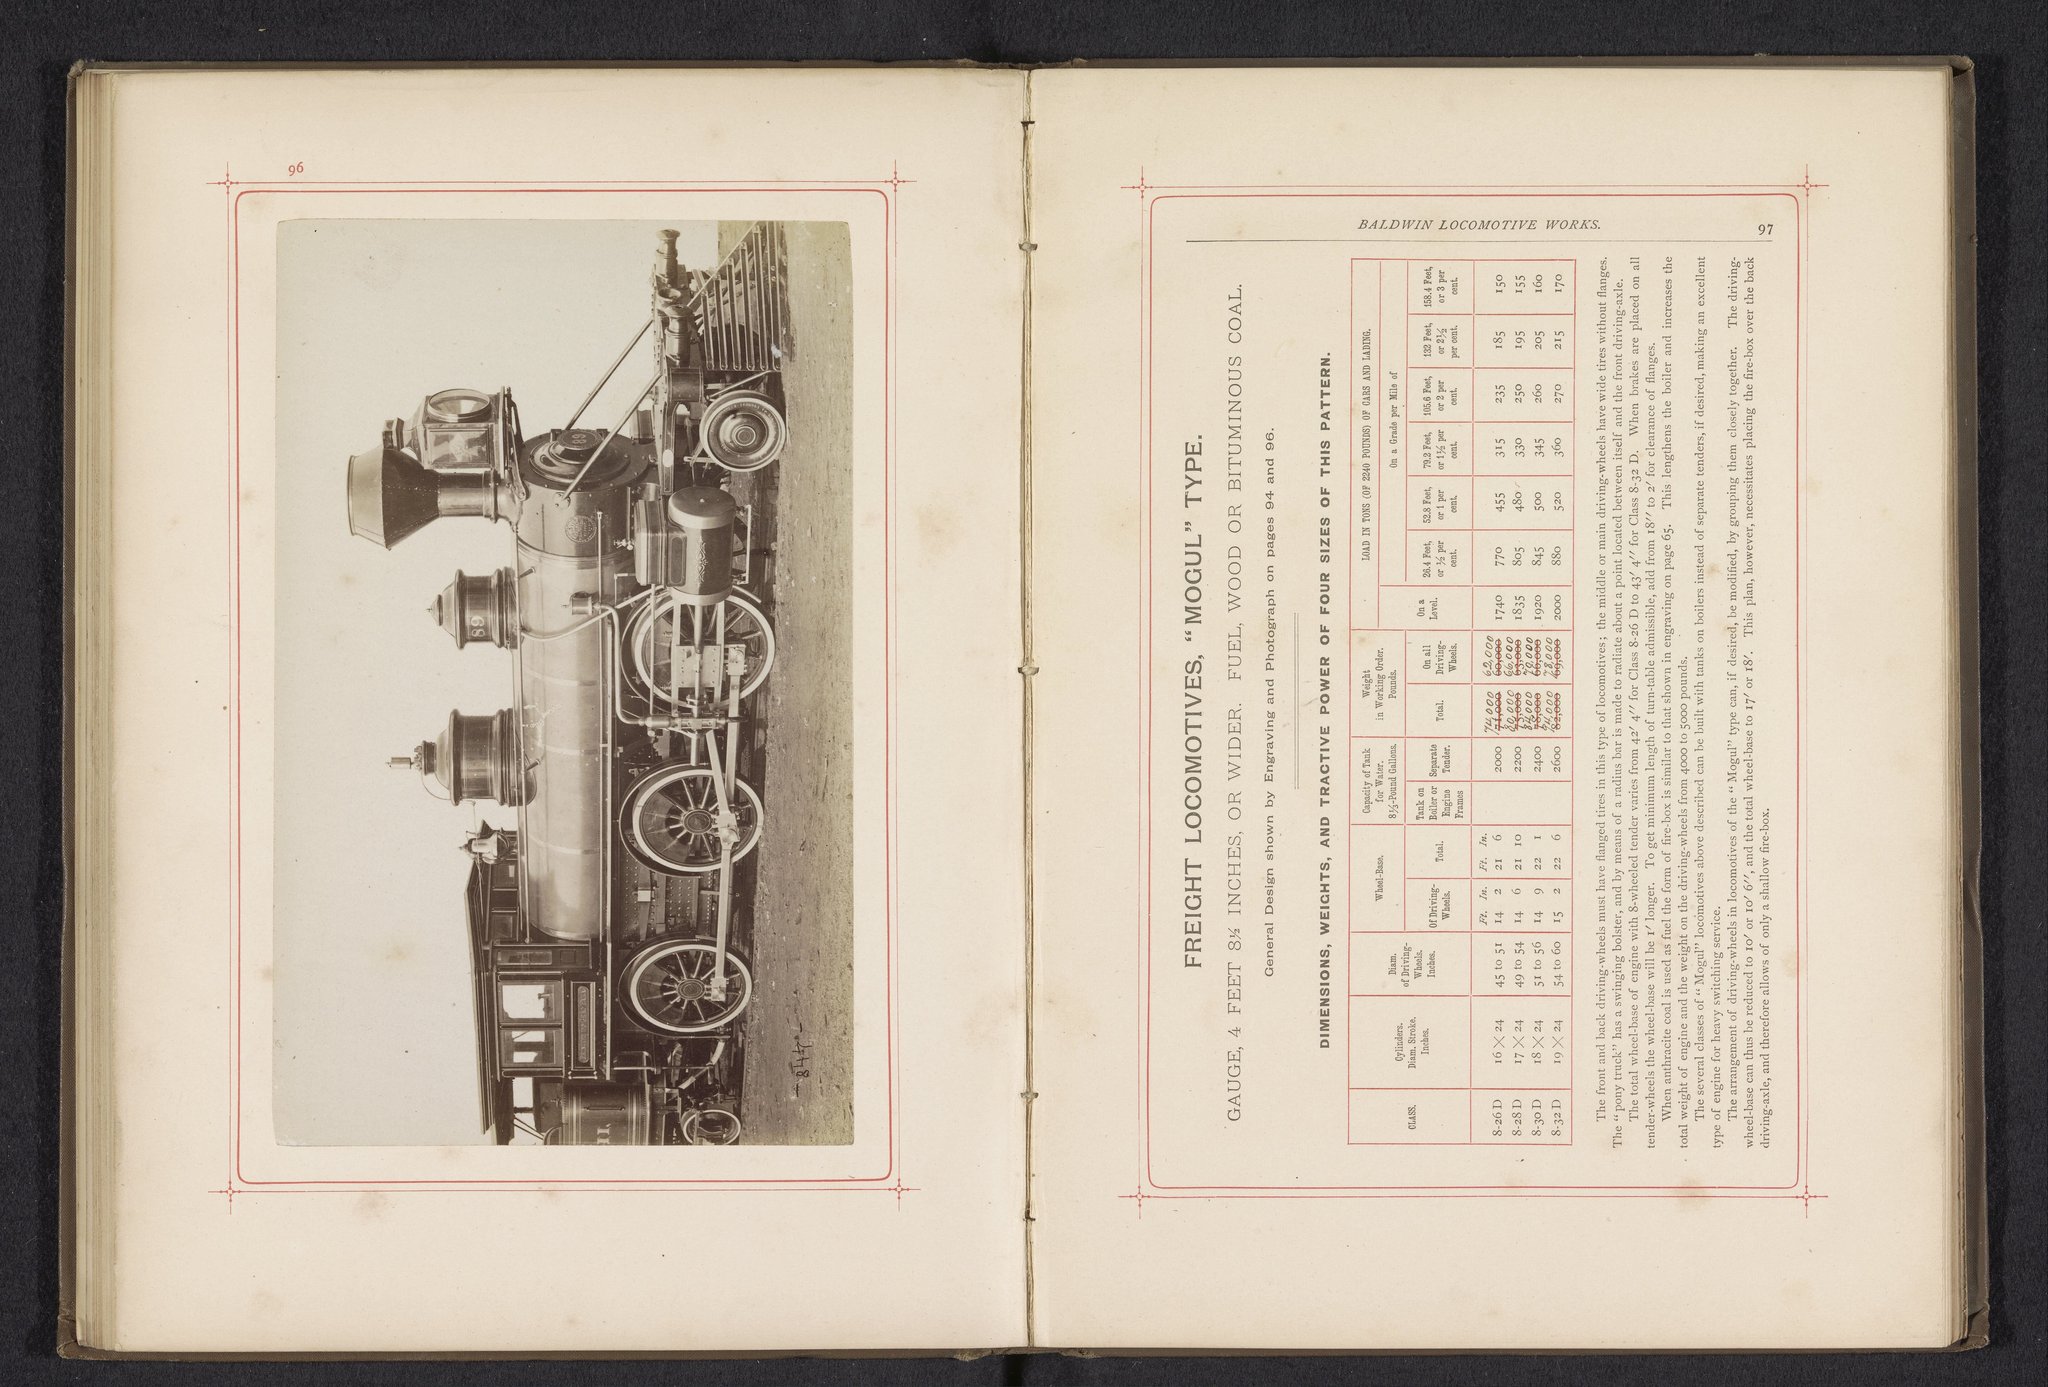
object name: page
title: Amerikaanse stoomlocomotief voor vrachtvervoer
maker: Anonymous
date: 1871-1881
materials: photographic support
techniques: albumen print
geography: united states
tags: steam locomotive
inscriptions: number: ‘844’